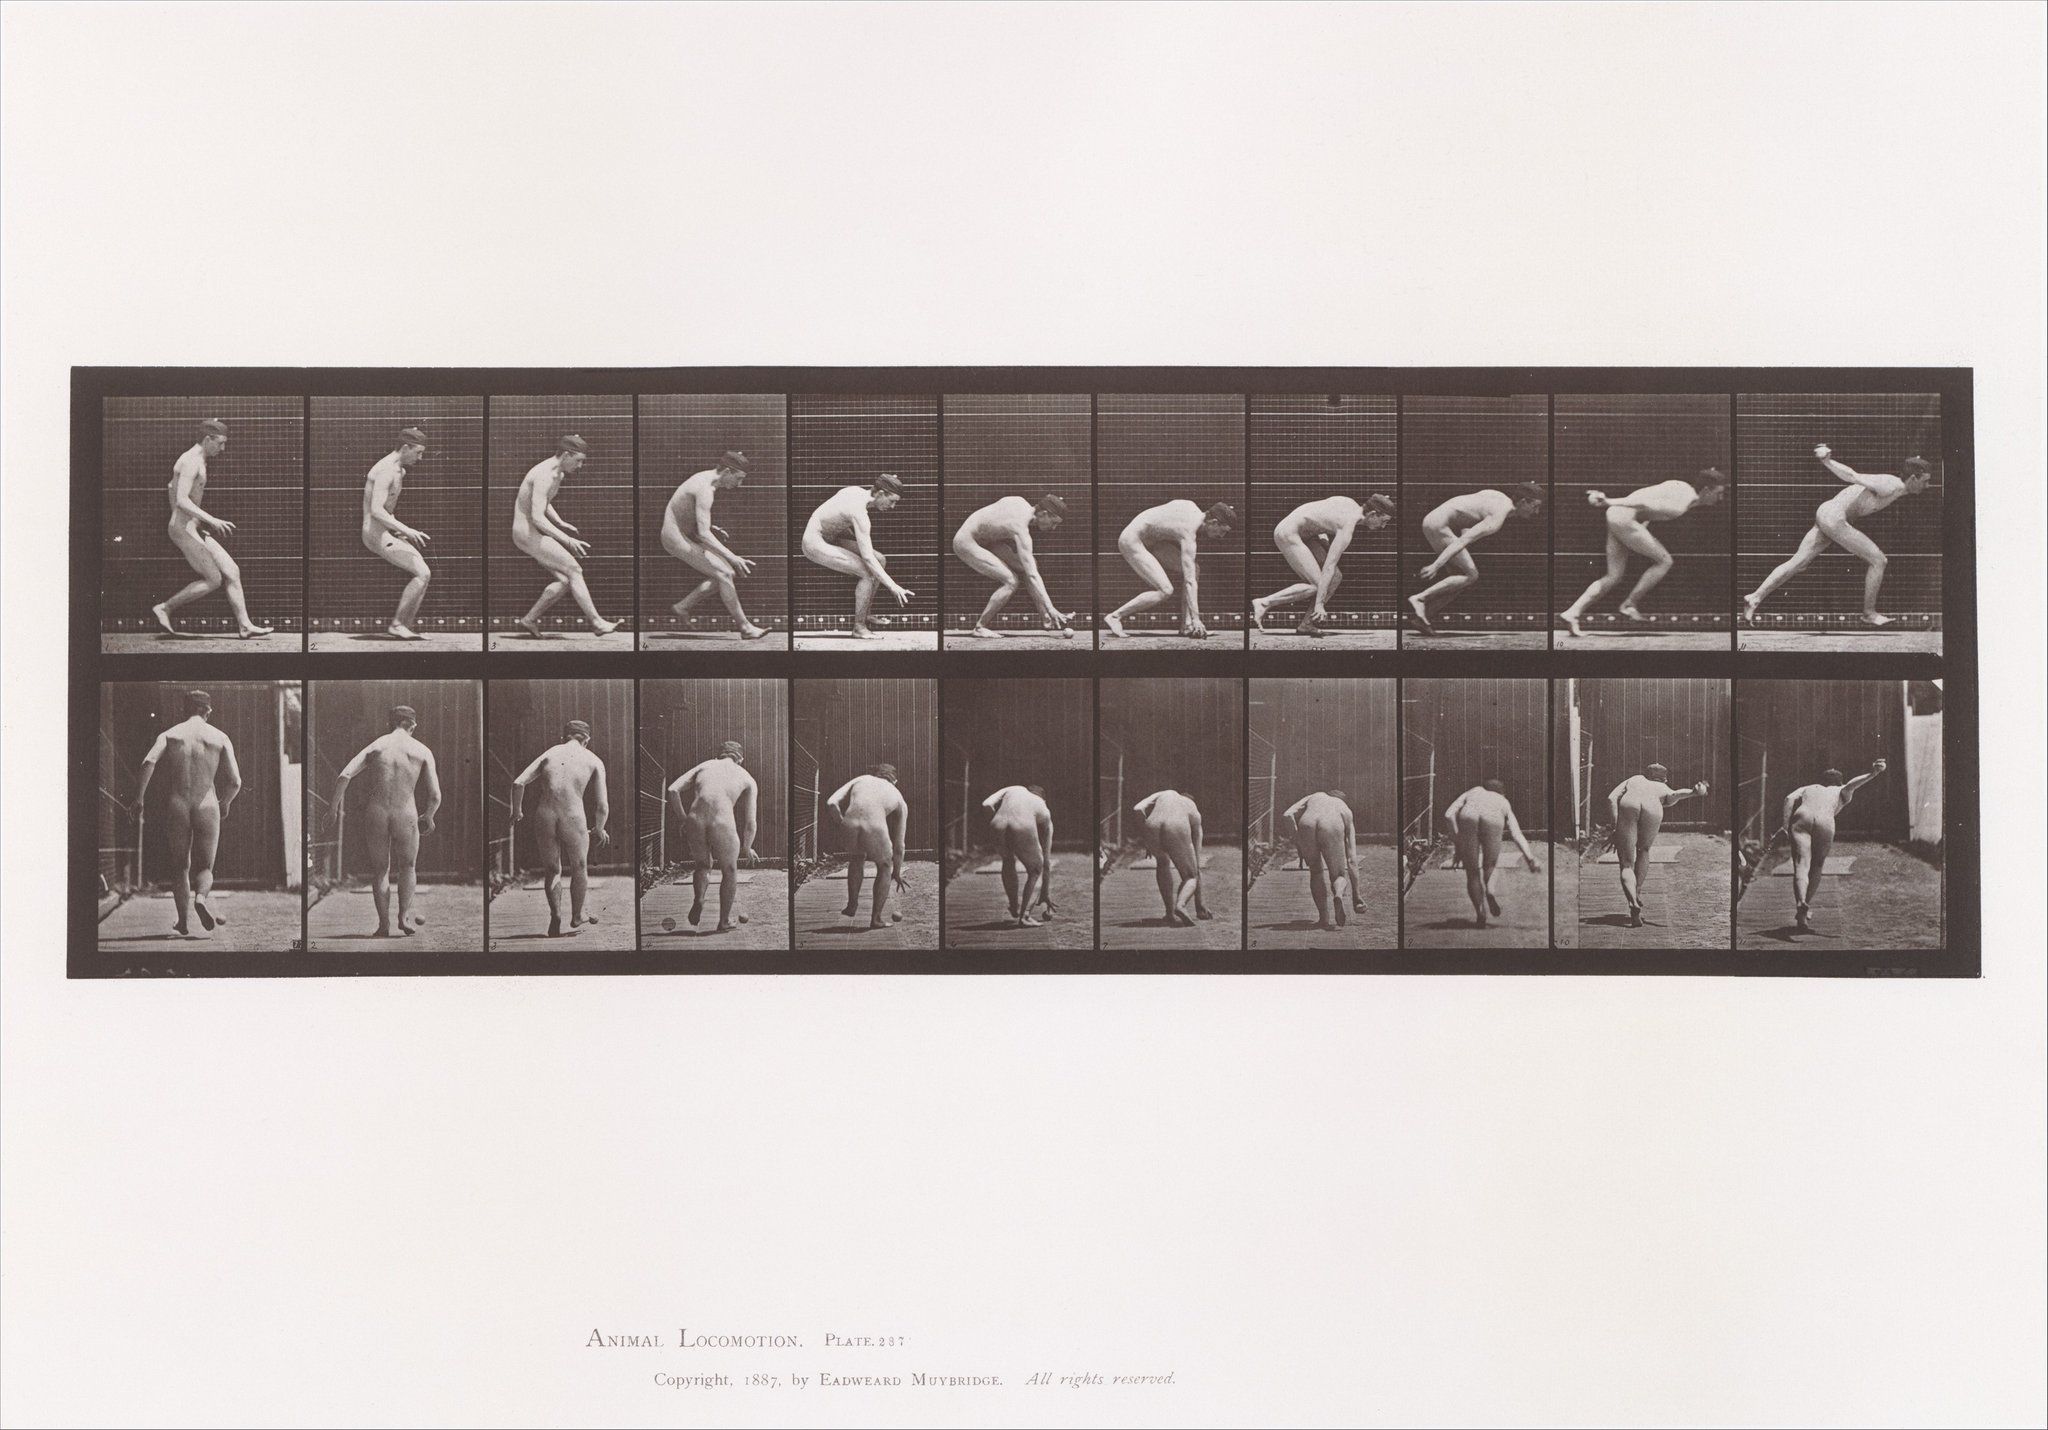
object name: photographically illustrated book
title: Animal Locomotion. An Electro-Photographic Investigation of Consecutive Phases of Animal Movements. Commenced 1872 - Completed 1885. Volume I, Men (Nude)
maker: eadweard muybridge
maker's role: artist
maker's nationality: british and american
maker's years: 1830-1904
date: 1880-1889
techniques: photogravure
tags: male nudes